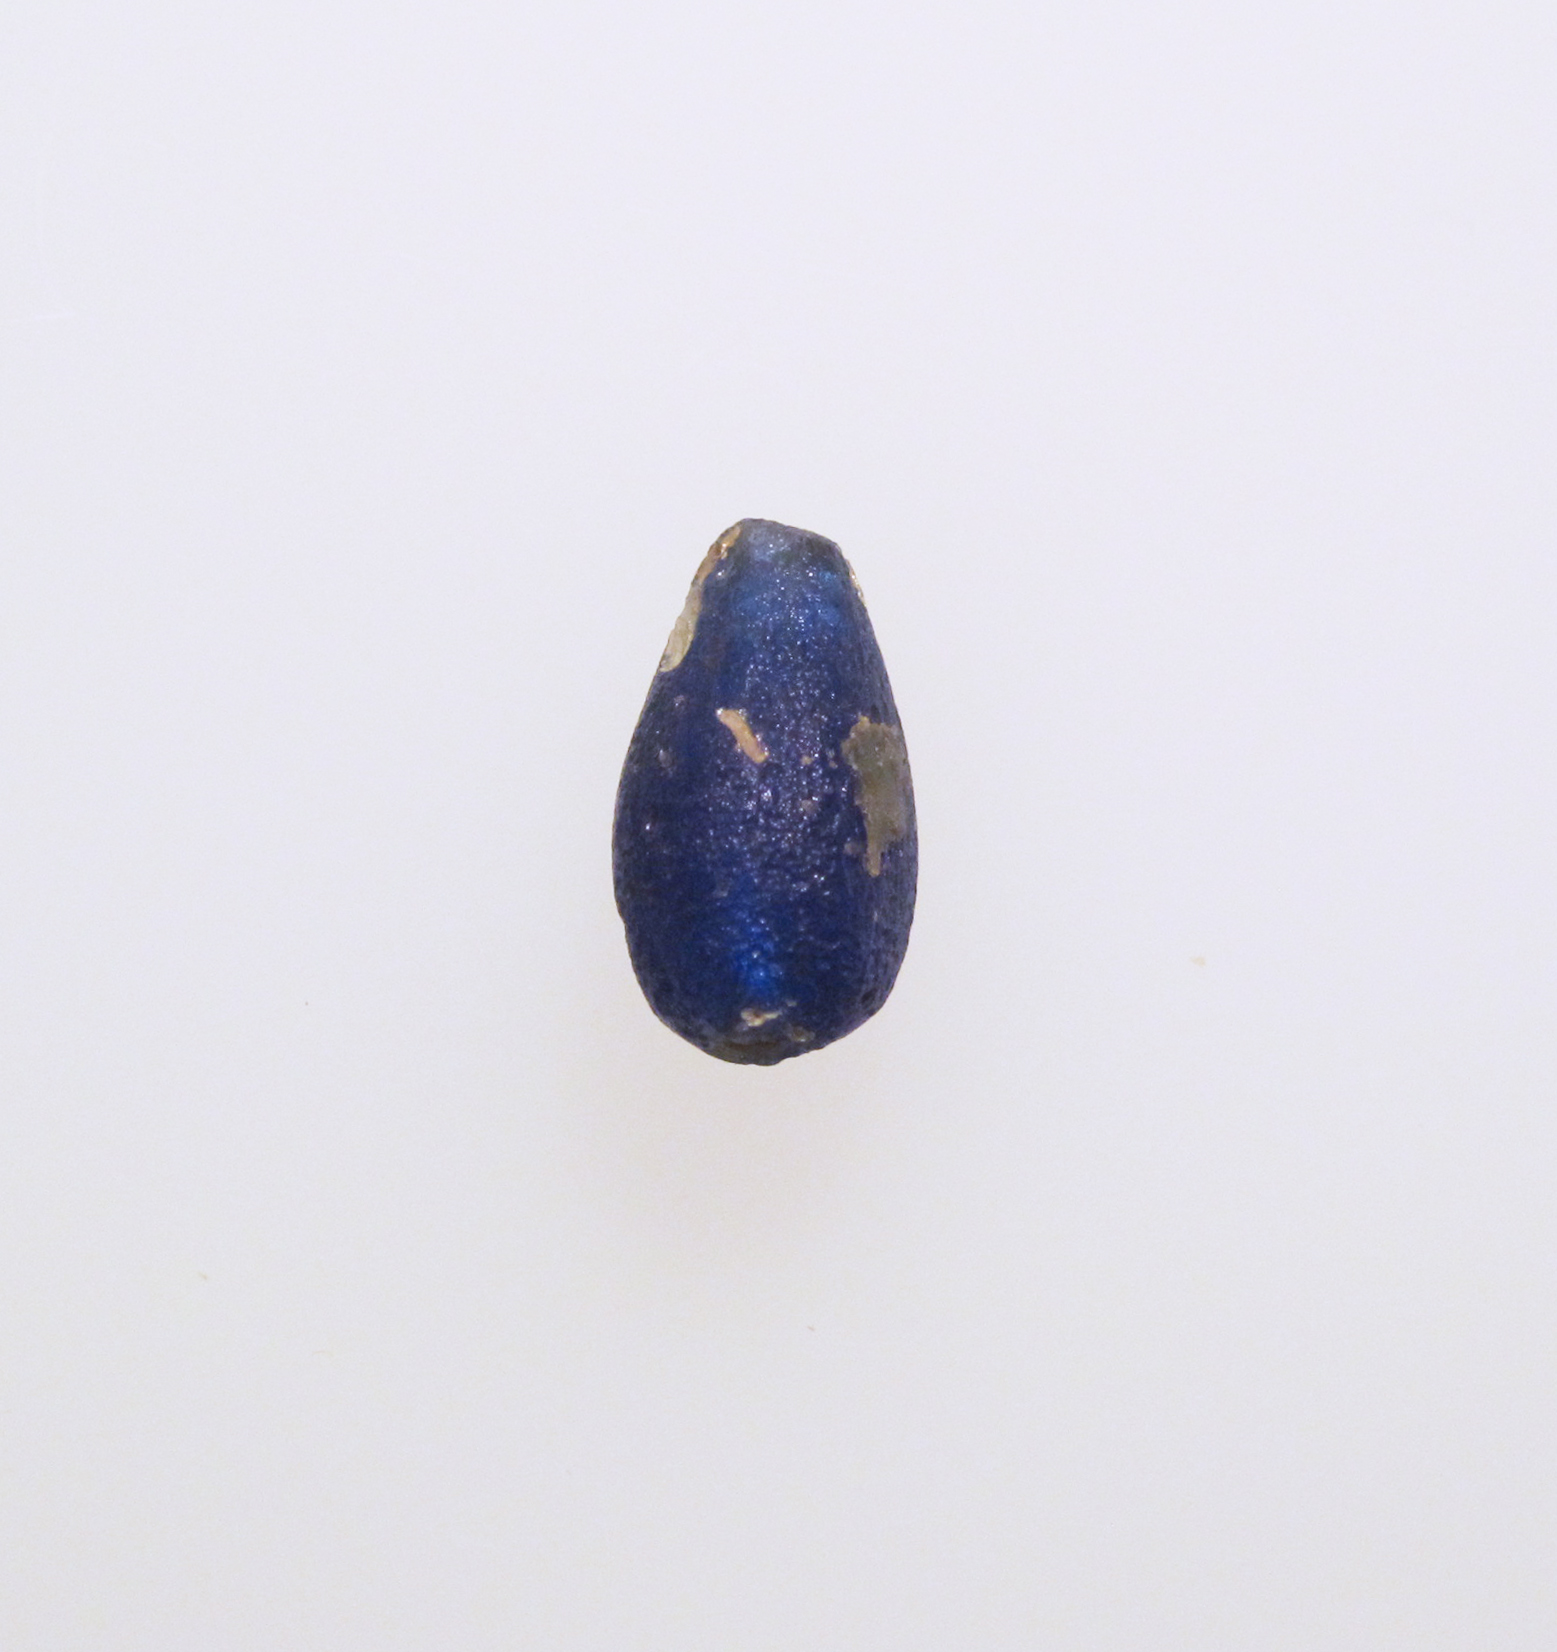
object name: bead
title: Glass bead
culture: roman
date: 1-100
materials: glass